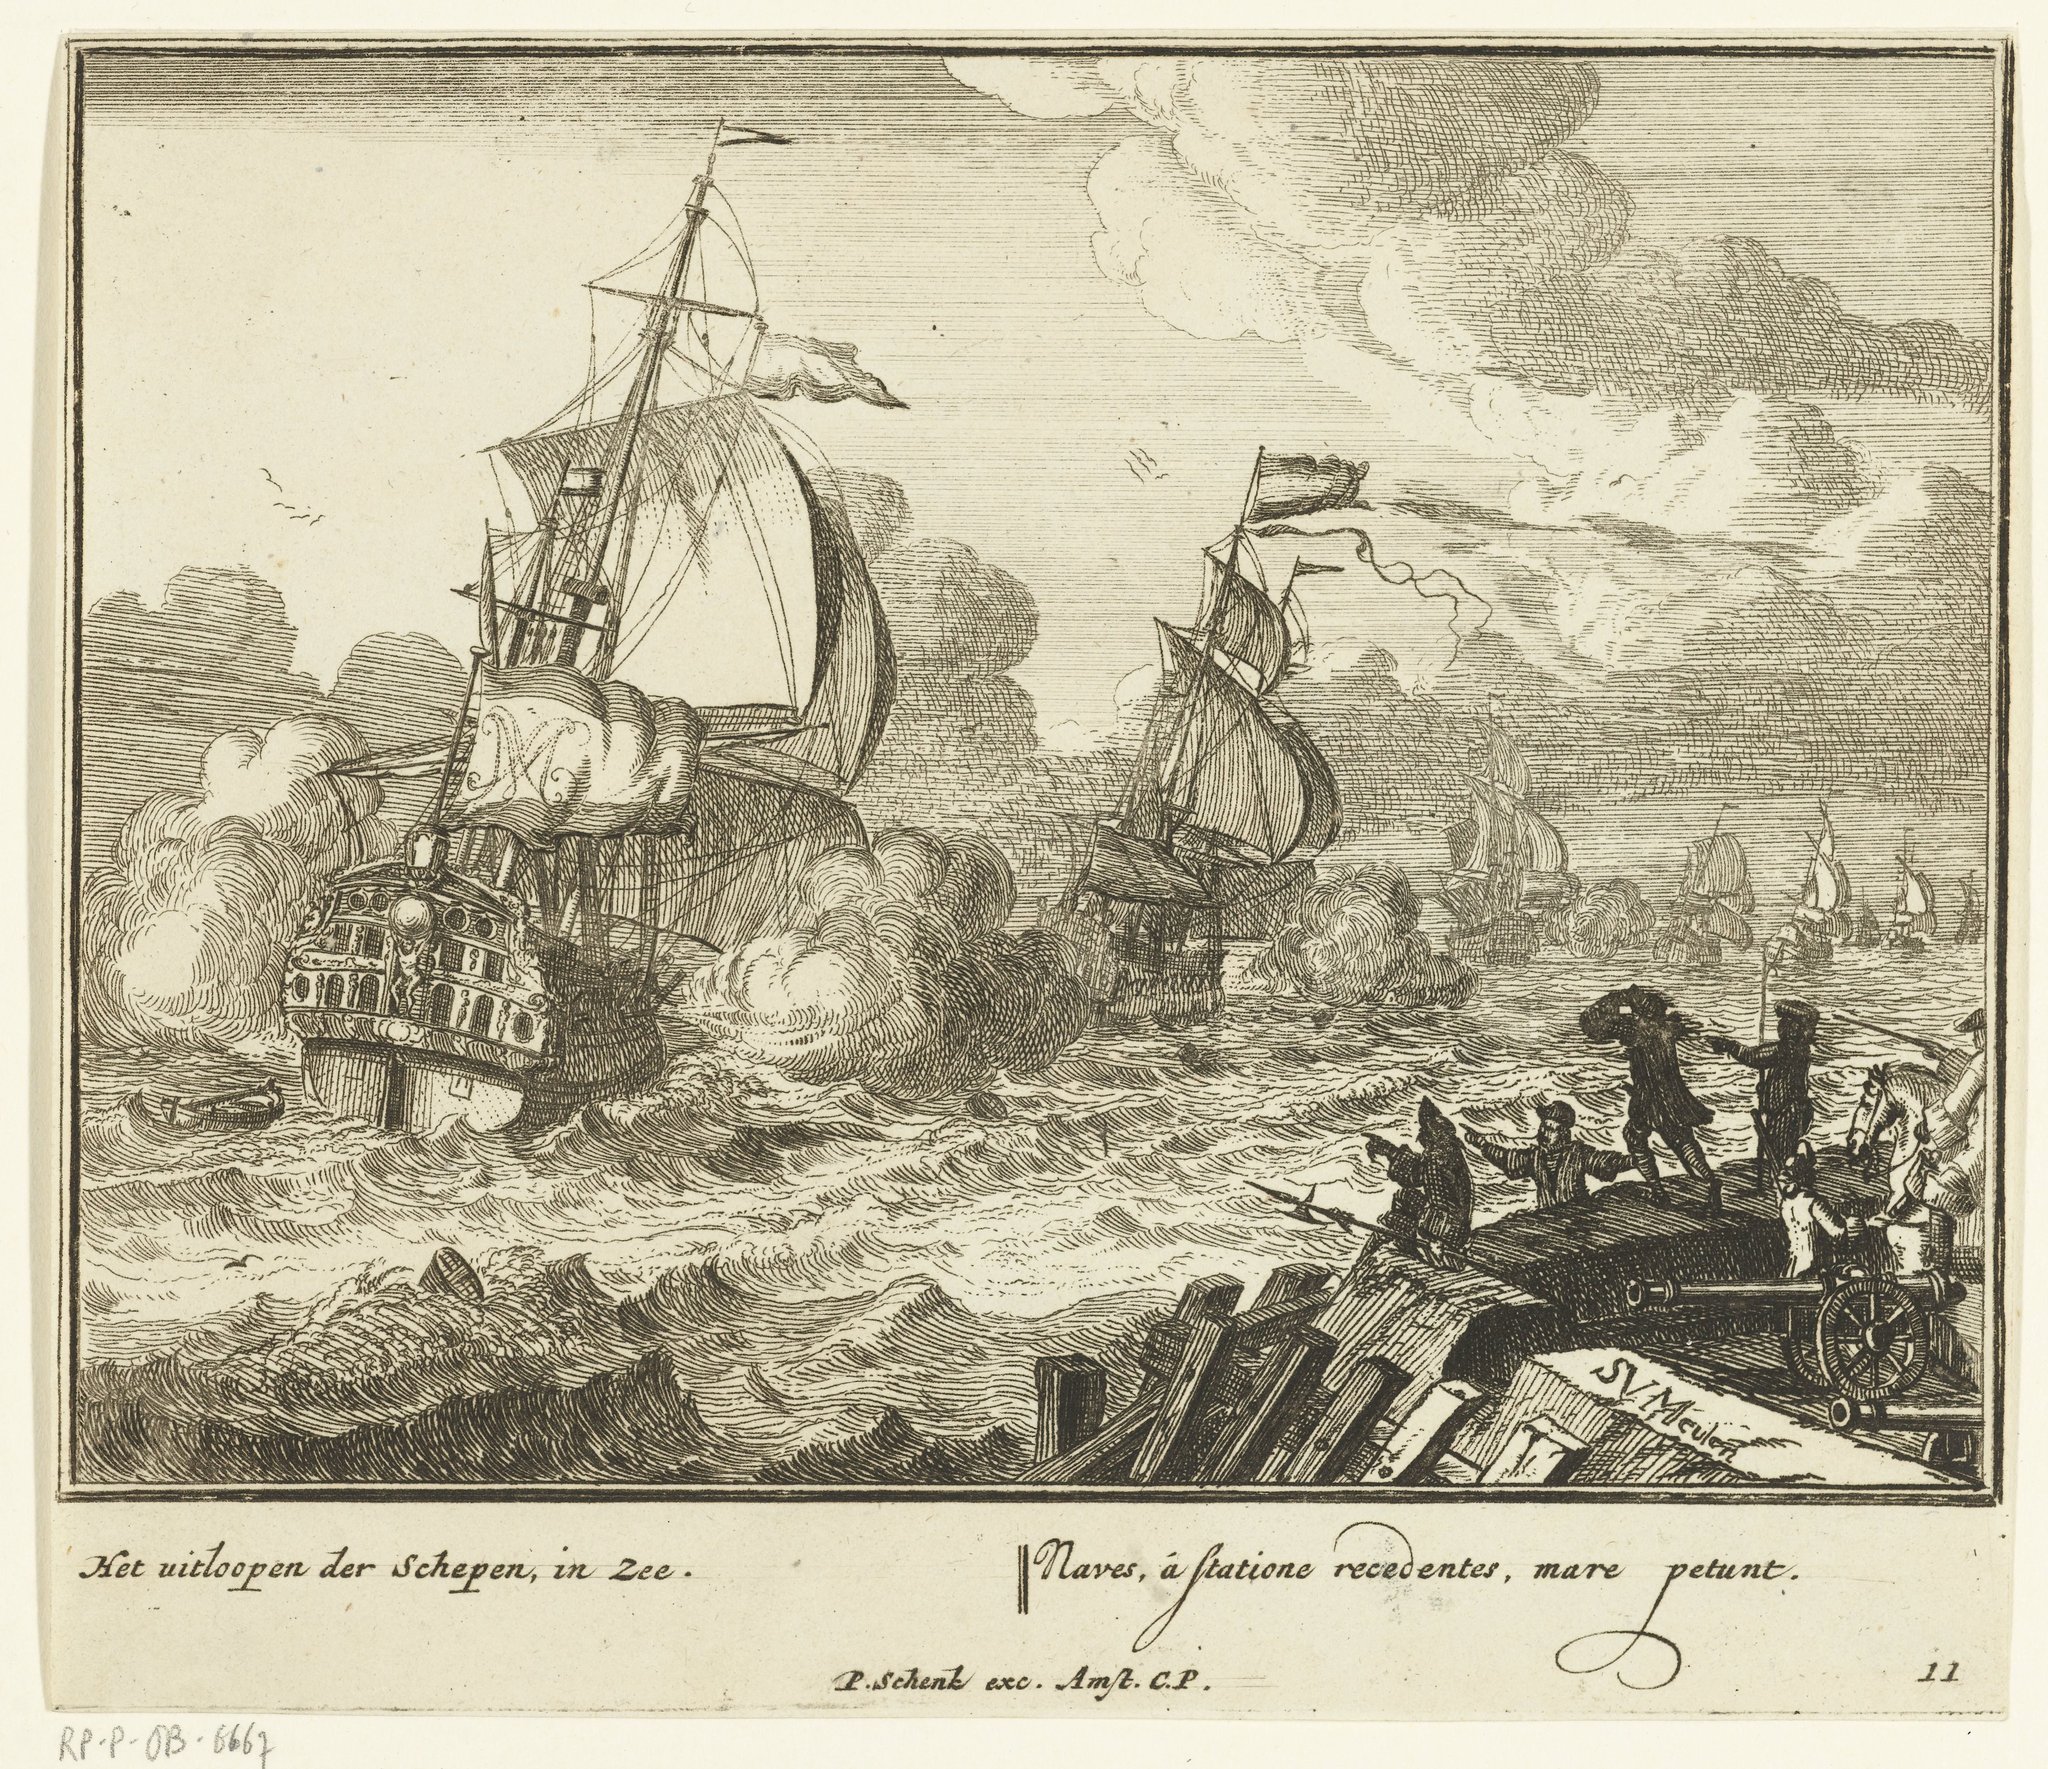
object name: print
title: Navigiorum Aedificatio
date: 1690-1710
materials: paper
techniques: etching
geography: northern netherlands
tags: battle (+ naval force)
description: Het schip neemt deel aan een gevecht voor de kust. No. 11 uit serie van 16 prenten waarop de bouw en lotgevallen van een schip zijn afgebeeld. Met onderschriften in het Nederlands en Latijn.